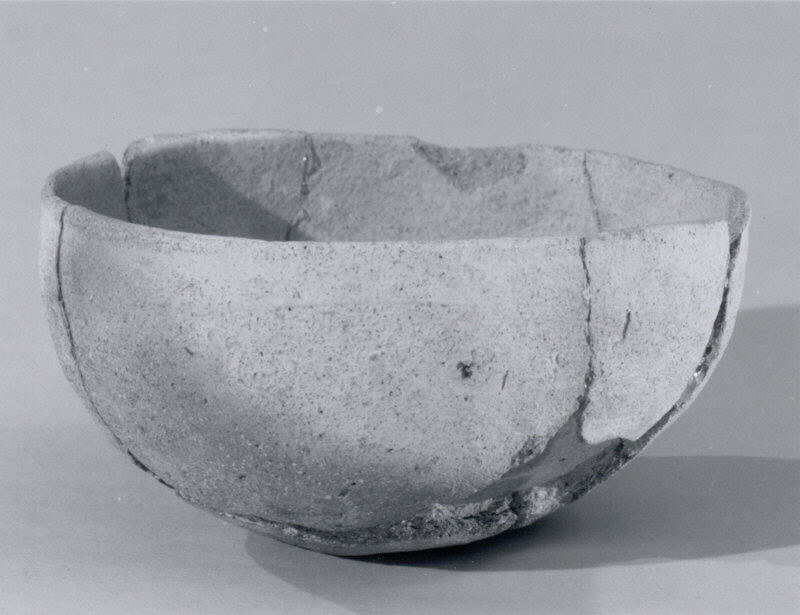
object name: bowl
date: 3500-3300 BCE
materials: ceramic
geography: levant